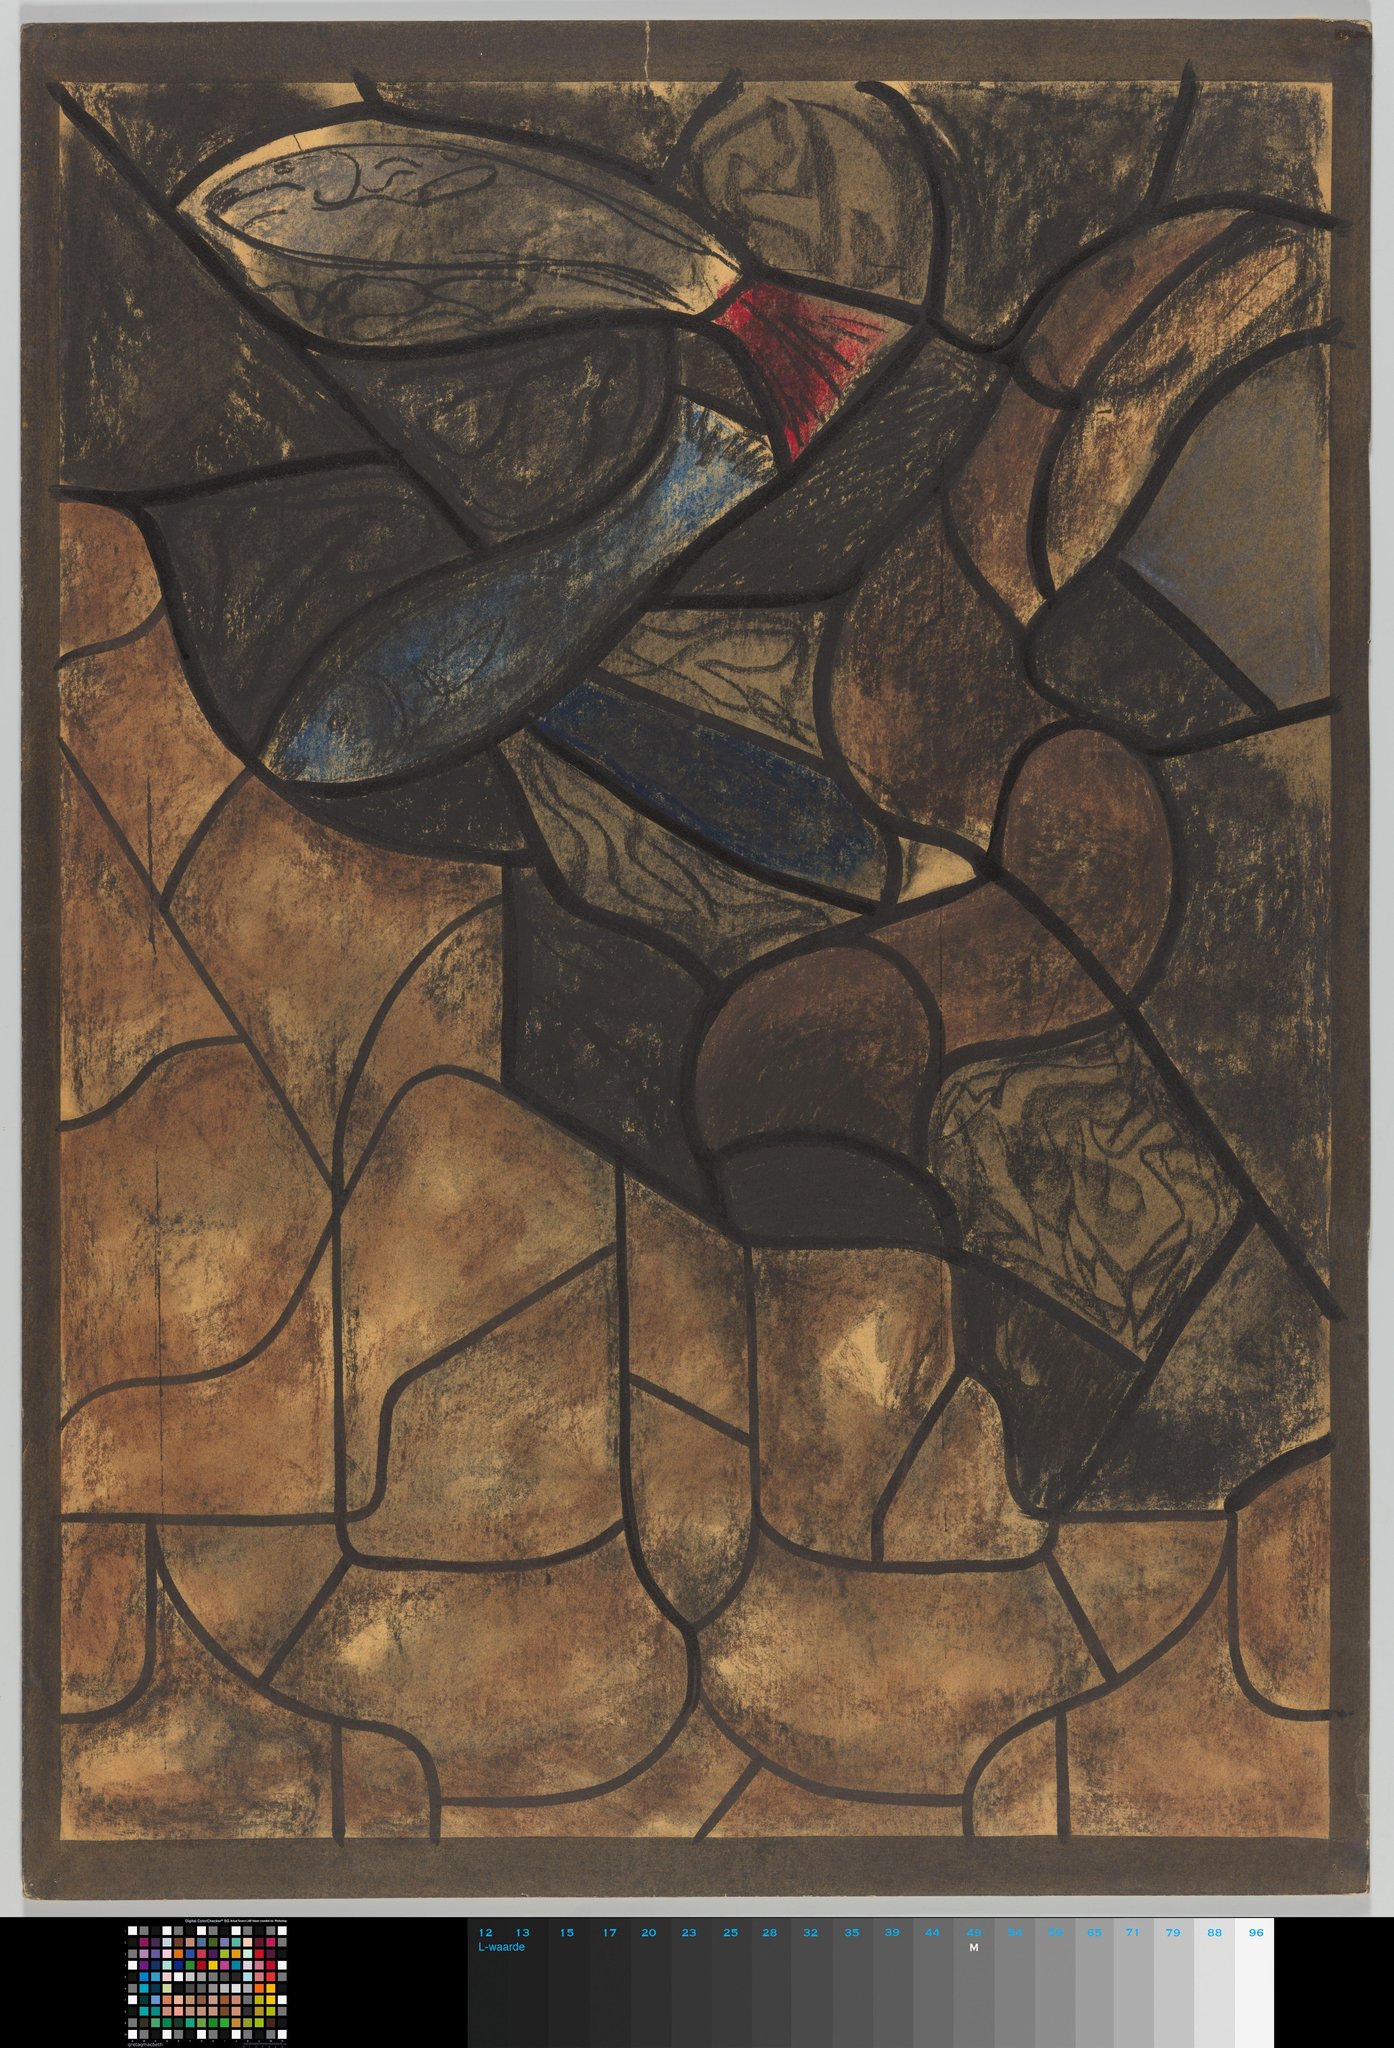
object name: drawing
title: Ontwerp voor raam in het Noordertransept in de Dom te Utrecht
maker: richard nicolaüs roland holst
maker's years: 1868-1938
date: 1934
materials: cardboard, chalk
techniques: brush